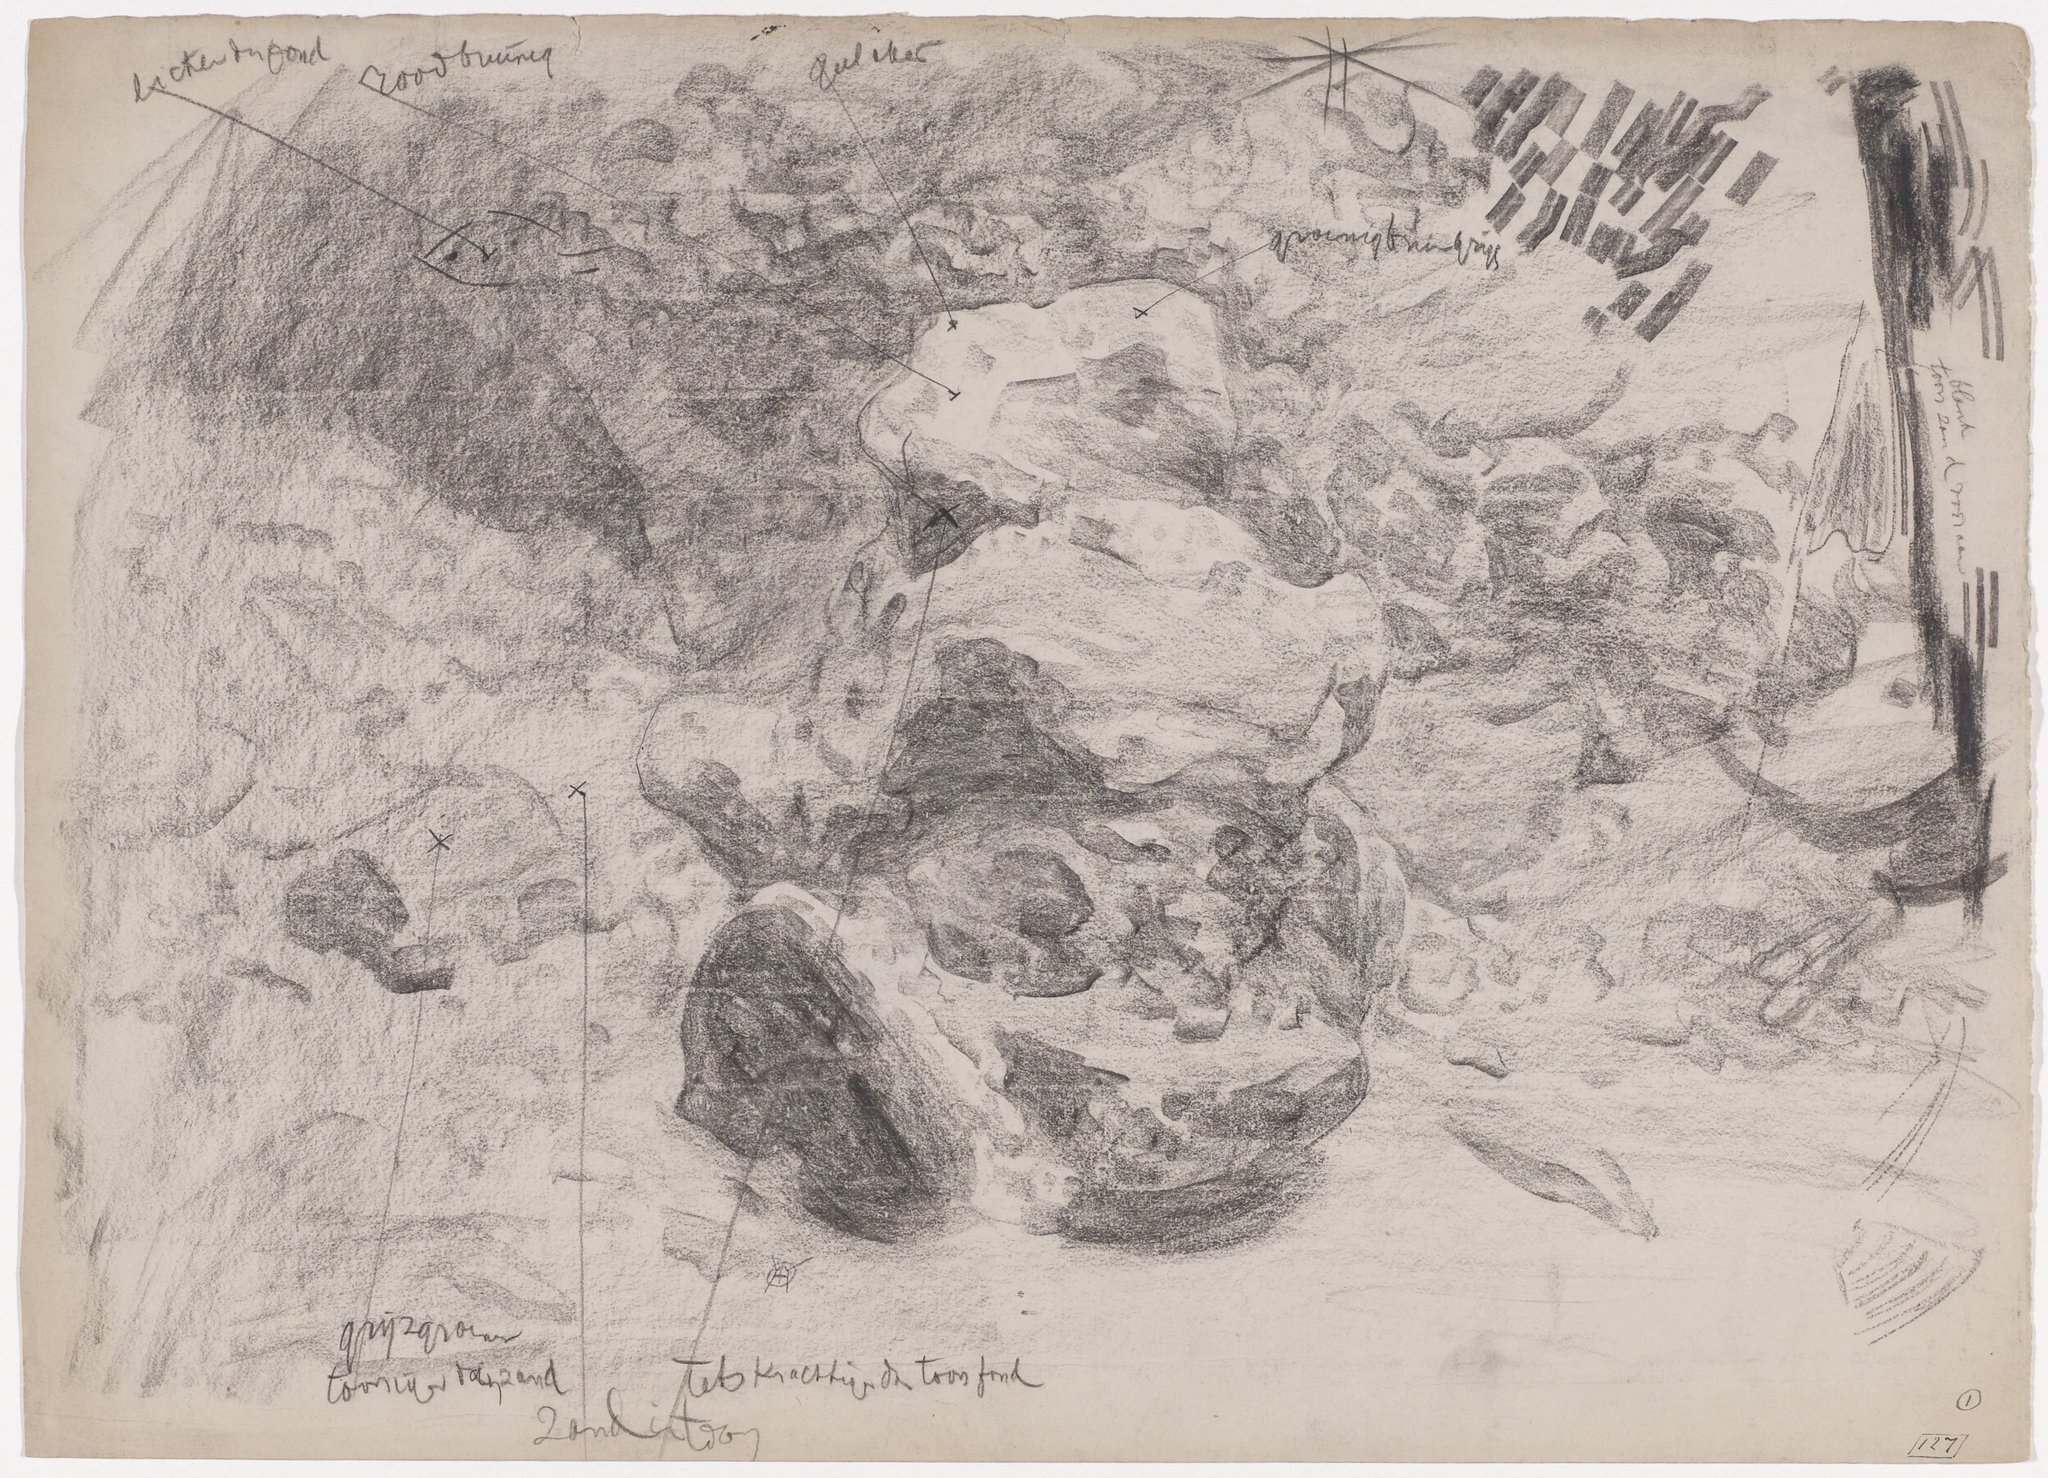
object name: drawing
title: Schets van een aquarium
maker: gerrit willem dijsselhof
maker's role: designer, draughtsman, print maker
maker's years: 1866-1924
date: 1876-1924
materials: chalk, paper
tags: aquarium